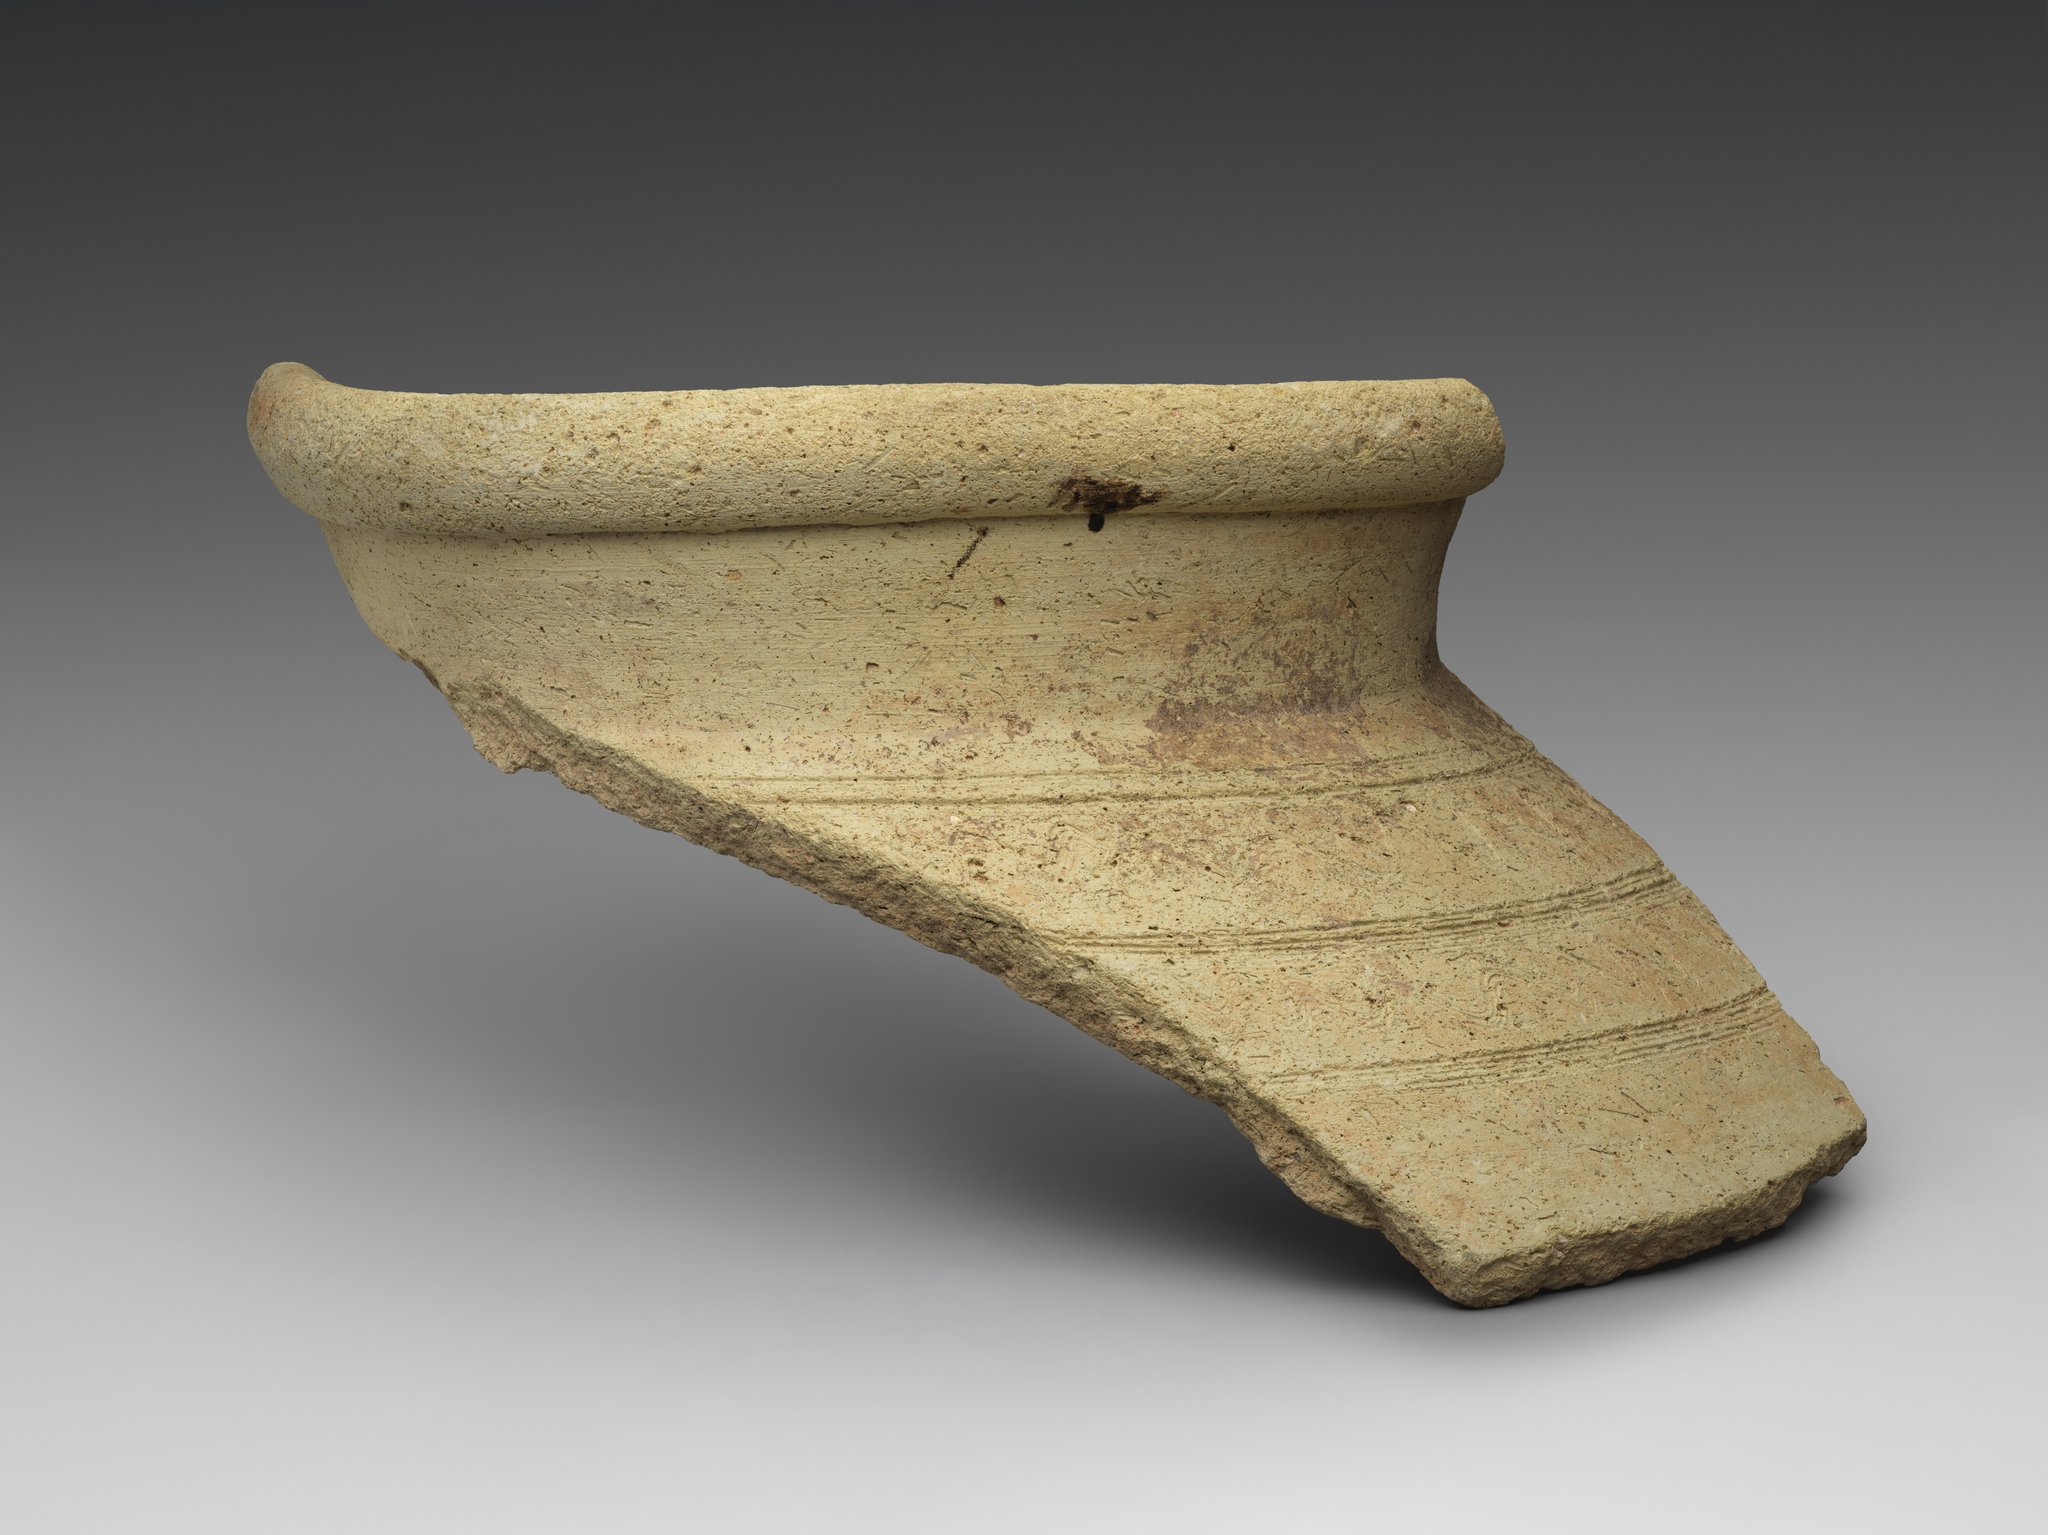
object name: jar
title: Jar rim sherd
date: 2333-2001 BCE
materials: ceramic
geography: mesopotamia